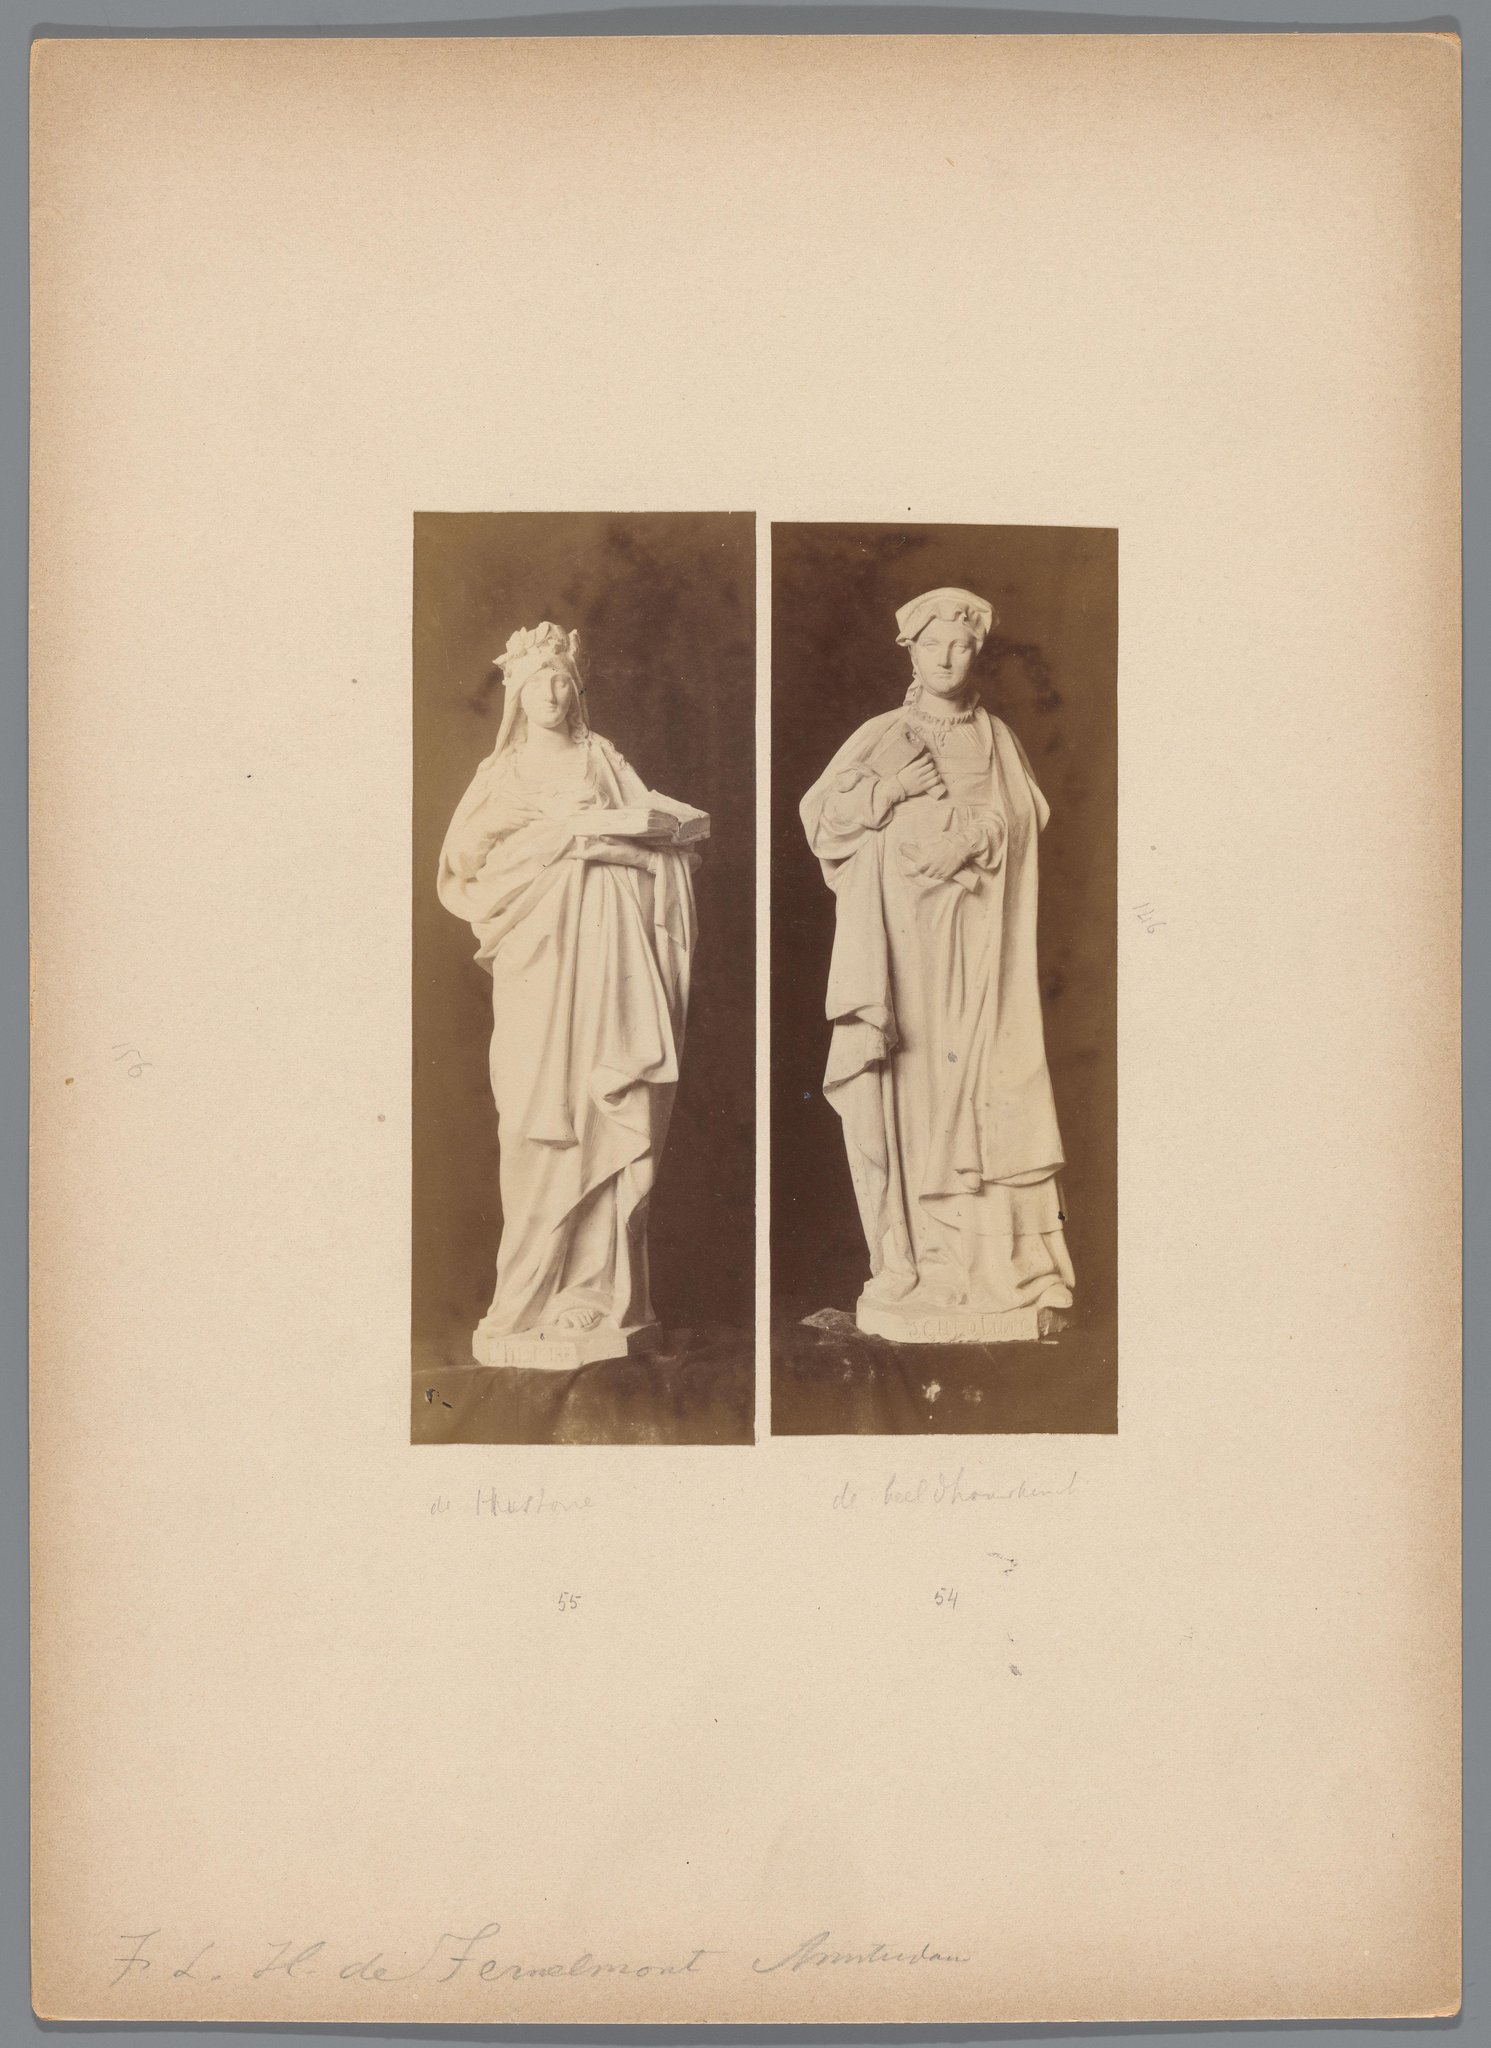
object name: reproduction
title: Fotoreproducties van de beeldhouwwerken De Historie en De Beeldhouwkunst door Franciscus van Camp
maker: Anonymous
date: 1880-1887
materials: cardboard, paper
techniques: albumen print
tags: 'sculptura', symbolic representations, allegories and emblems ~ sculpture; 'scoltura' (ripa), piece of sculpture, reproduction of a piece of sculpture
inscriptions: inscription: ‘F. L. H. de Fernelmont Amsterdam’, inscription: ‘55/ 54/ 156/ 146’, collector's mark: Lugt 2228